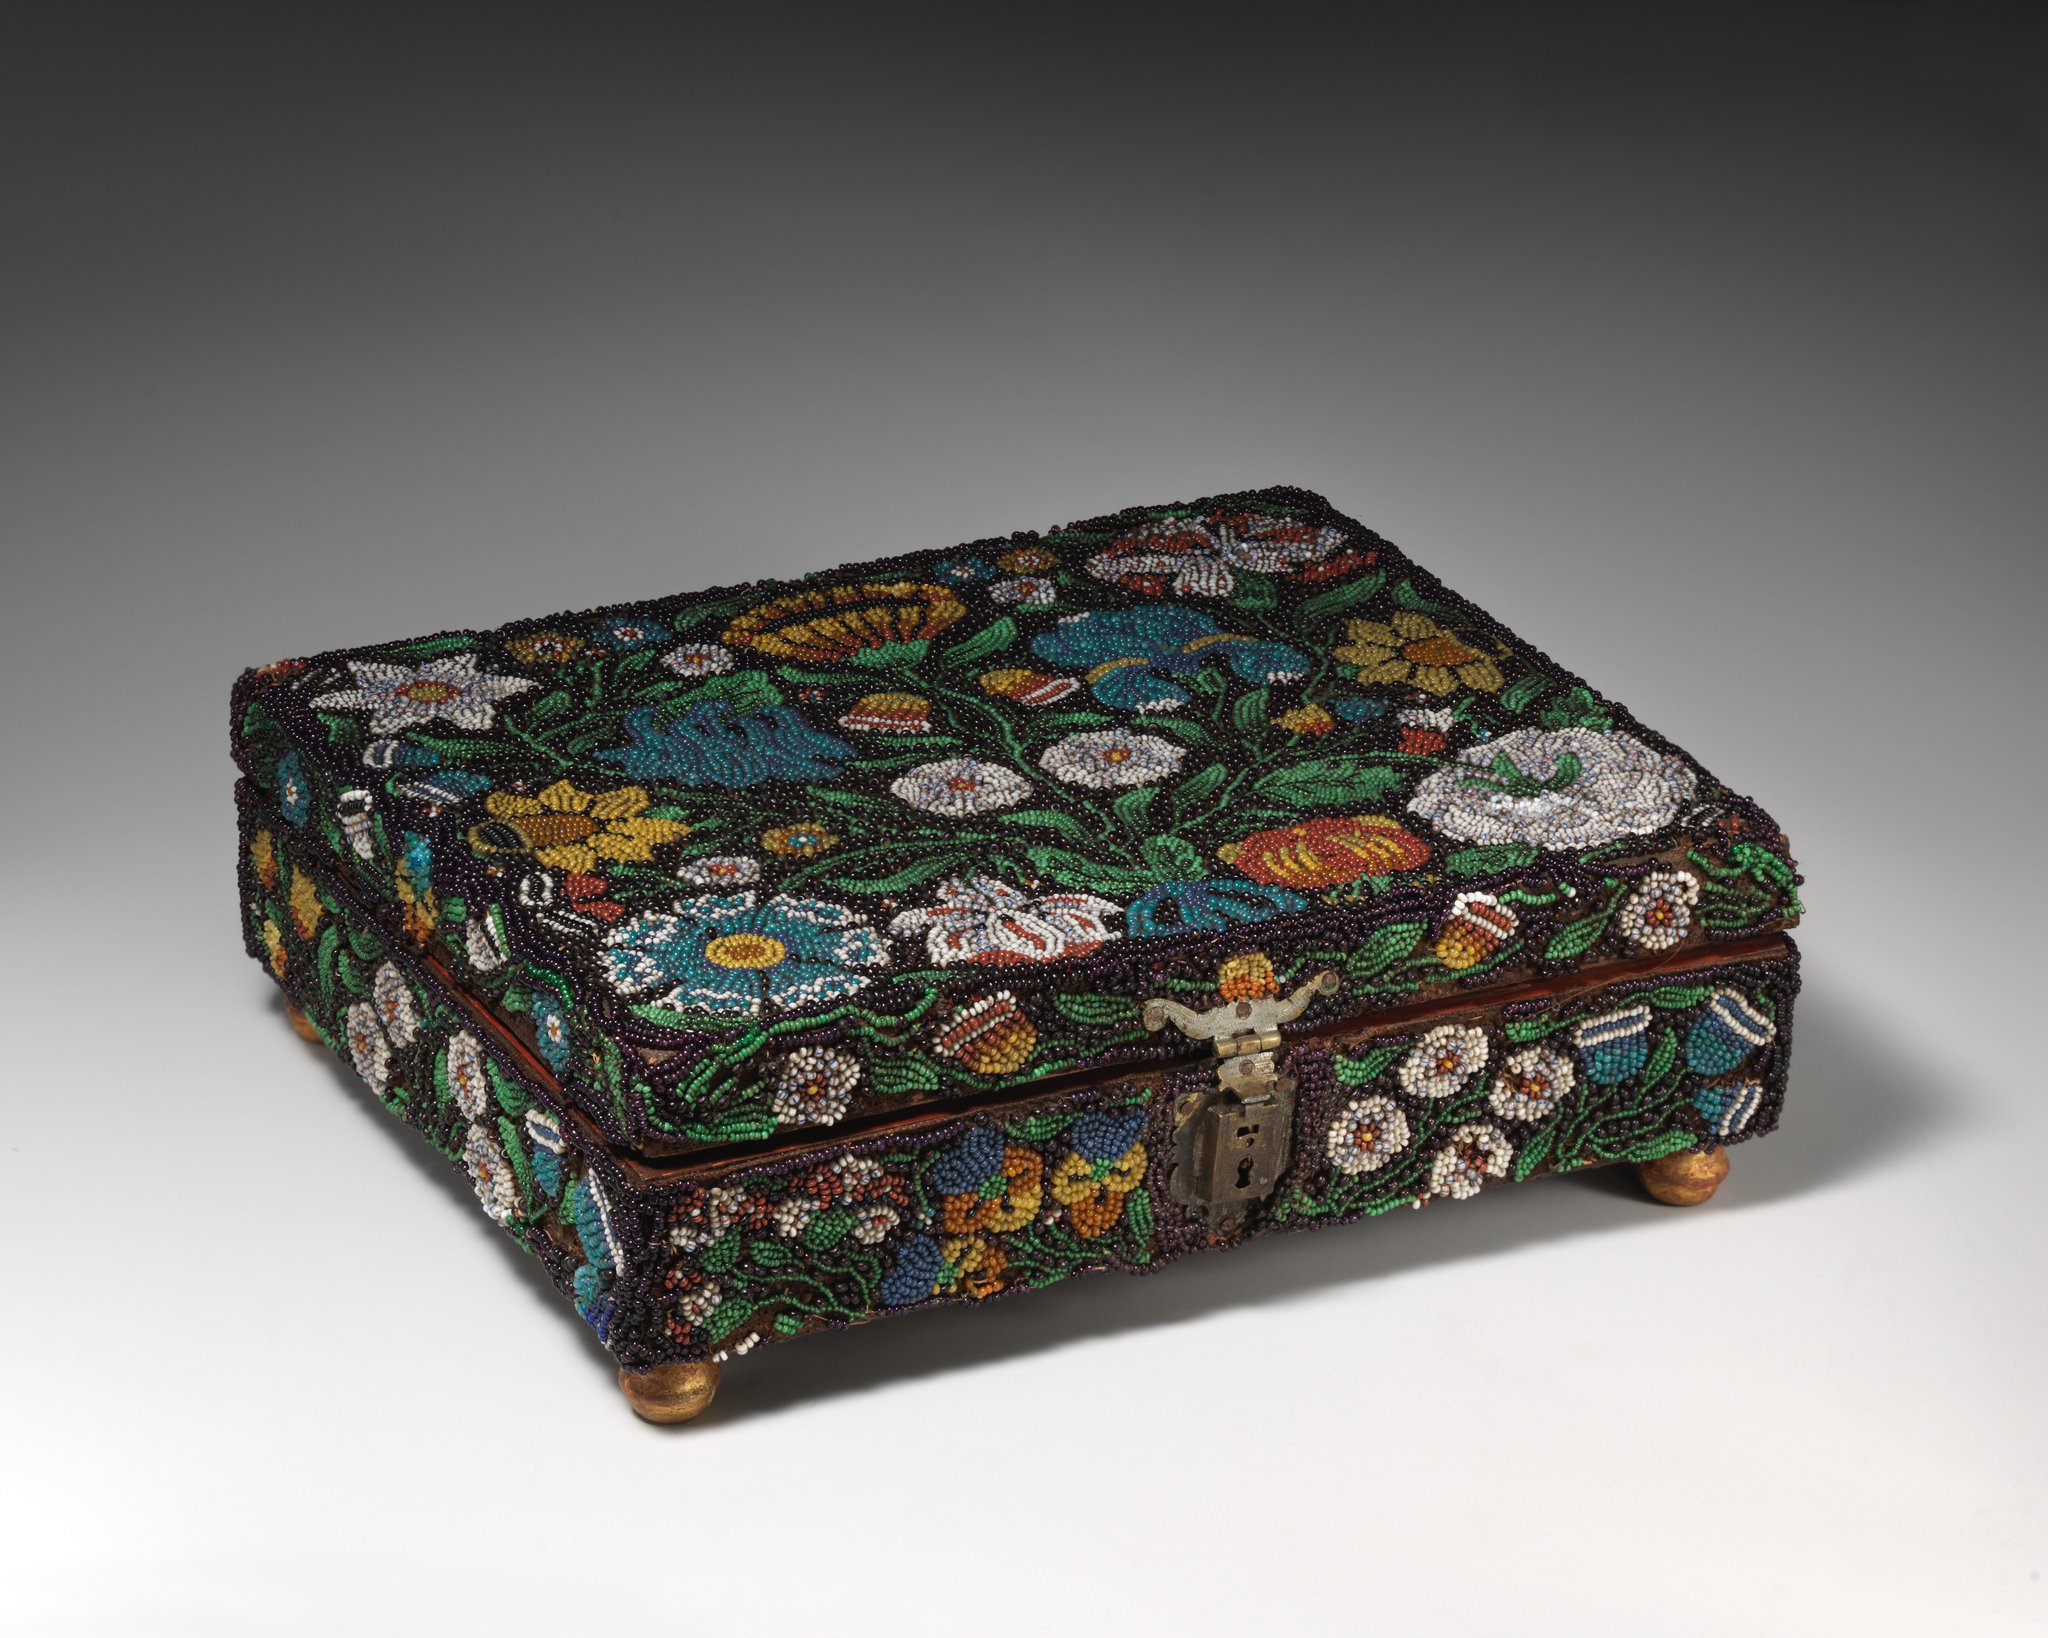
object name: box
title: Box with beadwork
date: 1676-1700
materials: canvas, wood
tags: flowers